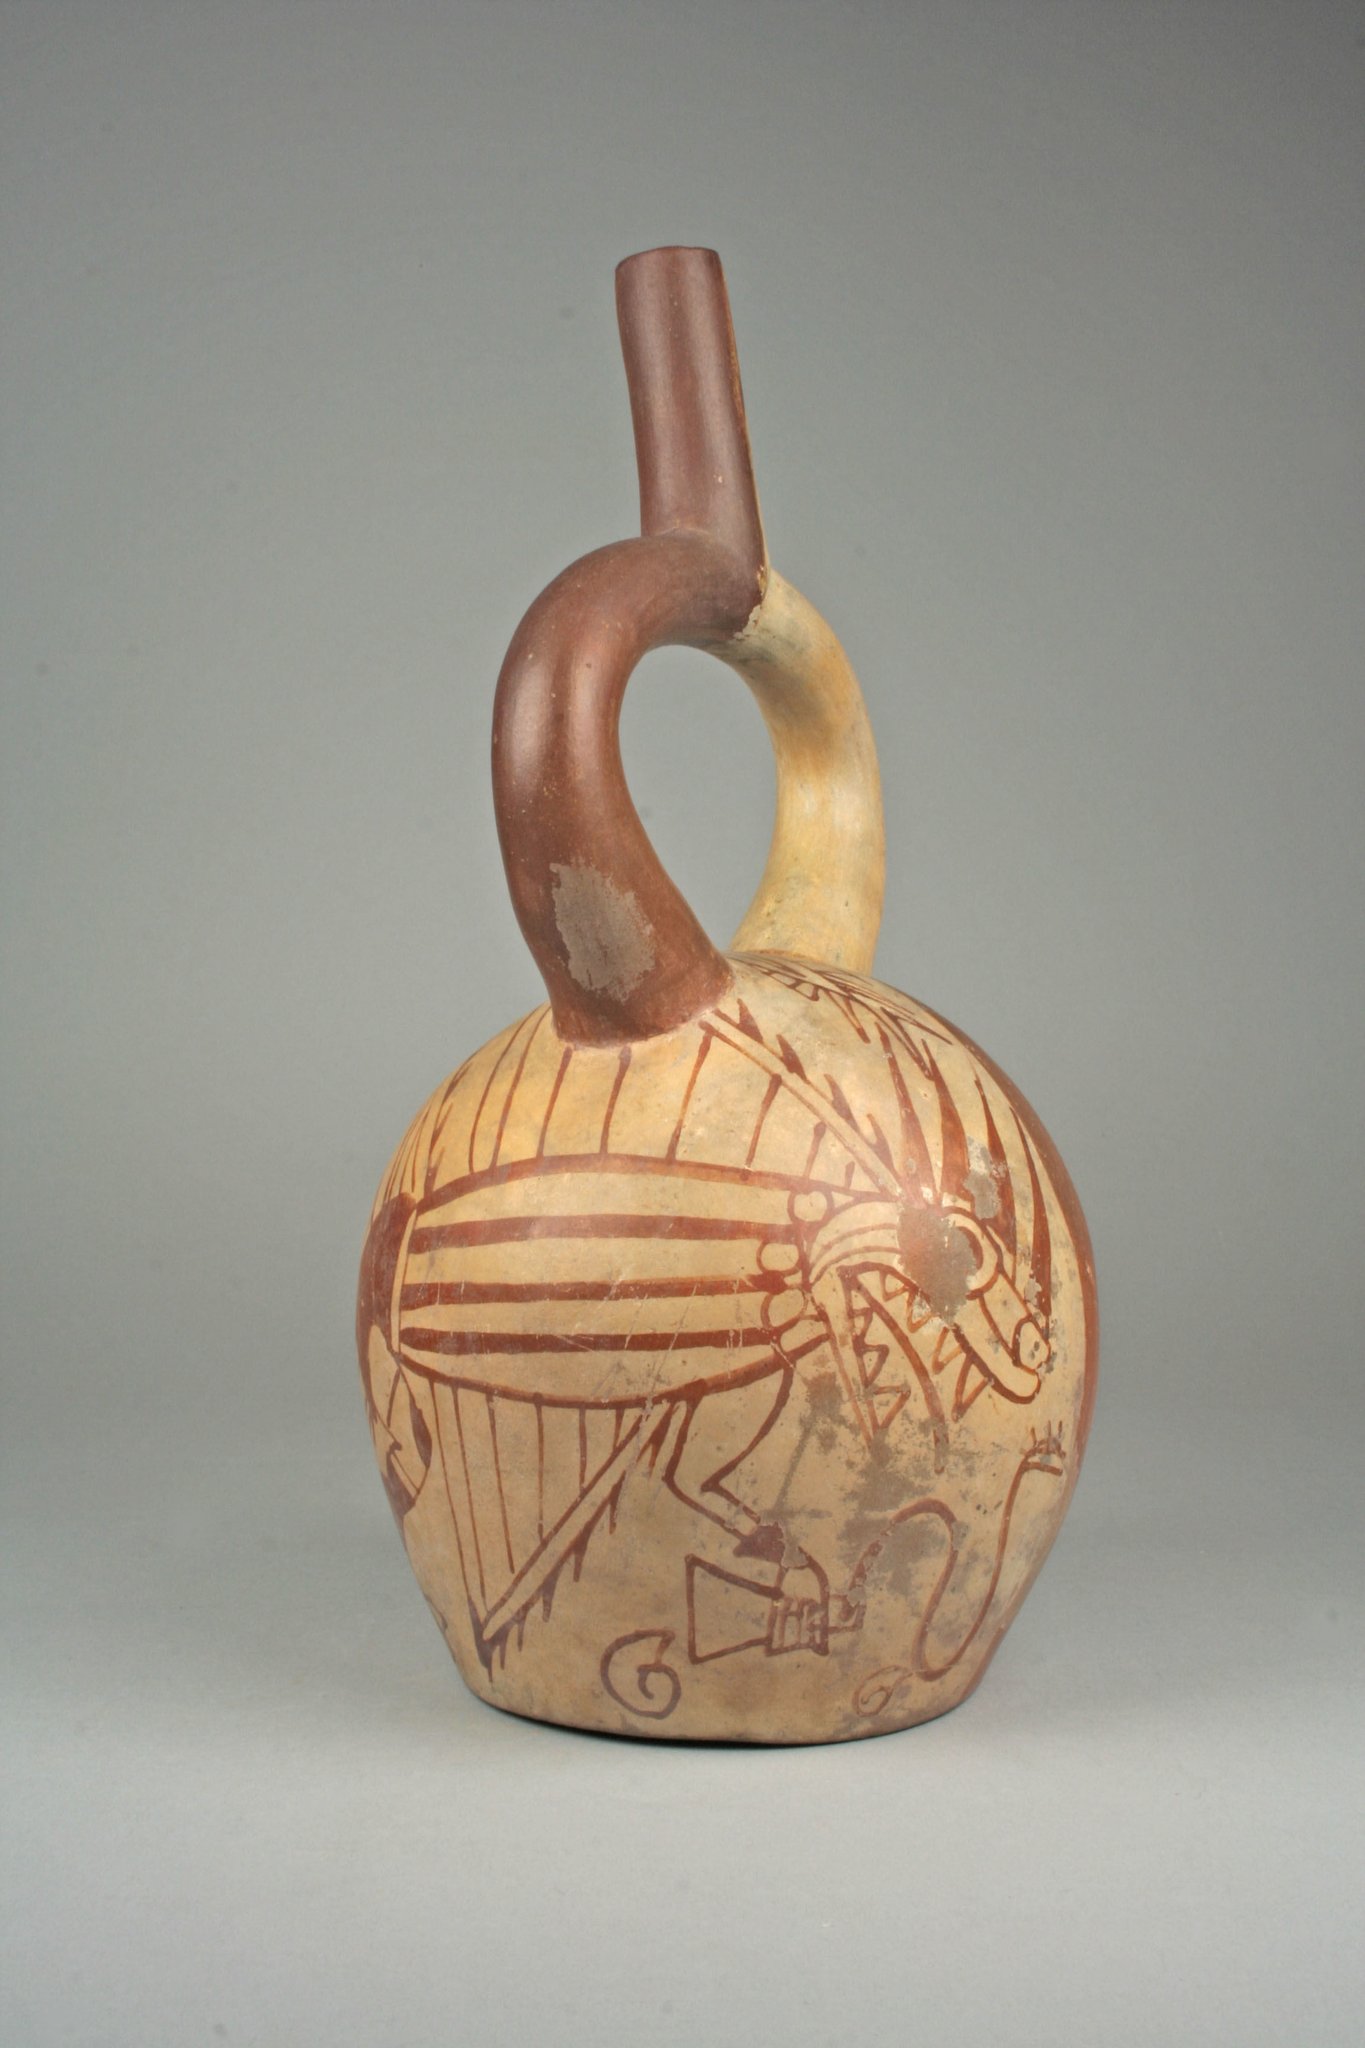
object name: bottle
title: Stirrup spout bottle with fish demon and tumi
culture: moche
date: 401-700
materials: ceramic, pigment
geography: peru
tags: demons